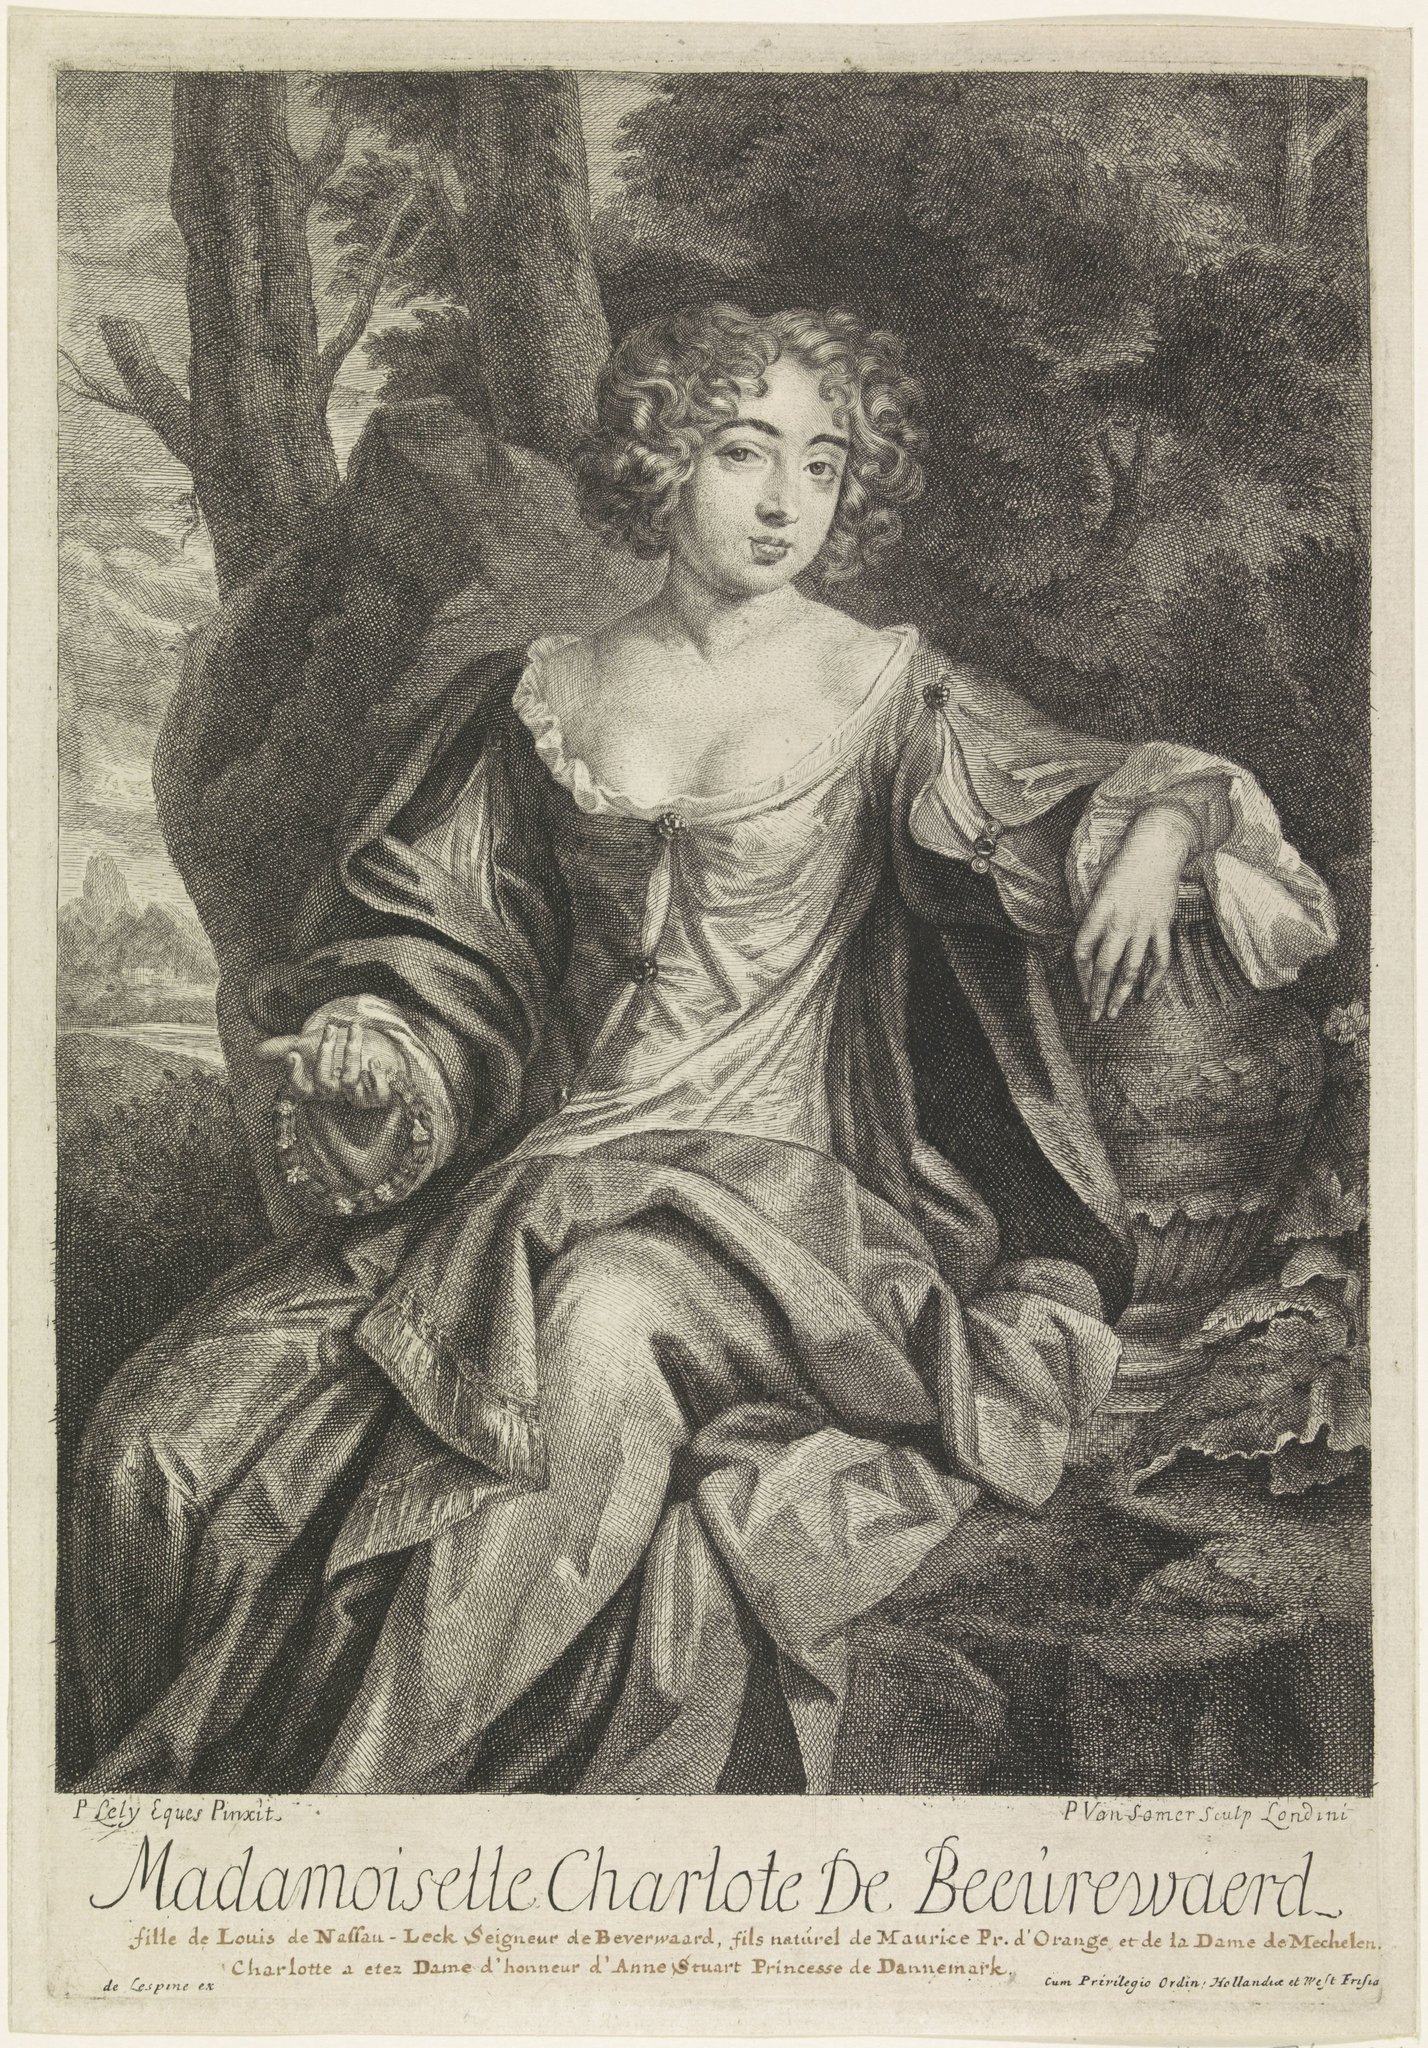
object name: print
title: Portret van Charlotte Philiberthe van Nassau-Beverweerd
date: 1675-1694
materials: paper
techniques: engraving, etching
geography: london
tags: charlotte philiberthe van nassau-beverweerd, huis nassau ottoonse linie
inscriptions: collector's mark: Lugt 2228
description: Portret van Charlotte Philiberthe. In haar rechterhand een bloemenkrans. Onder haar linkerarm een urn. In de ondermarge haar naam en titel.